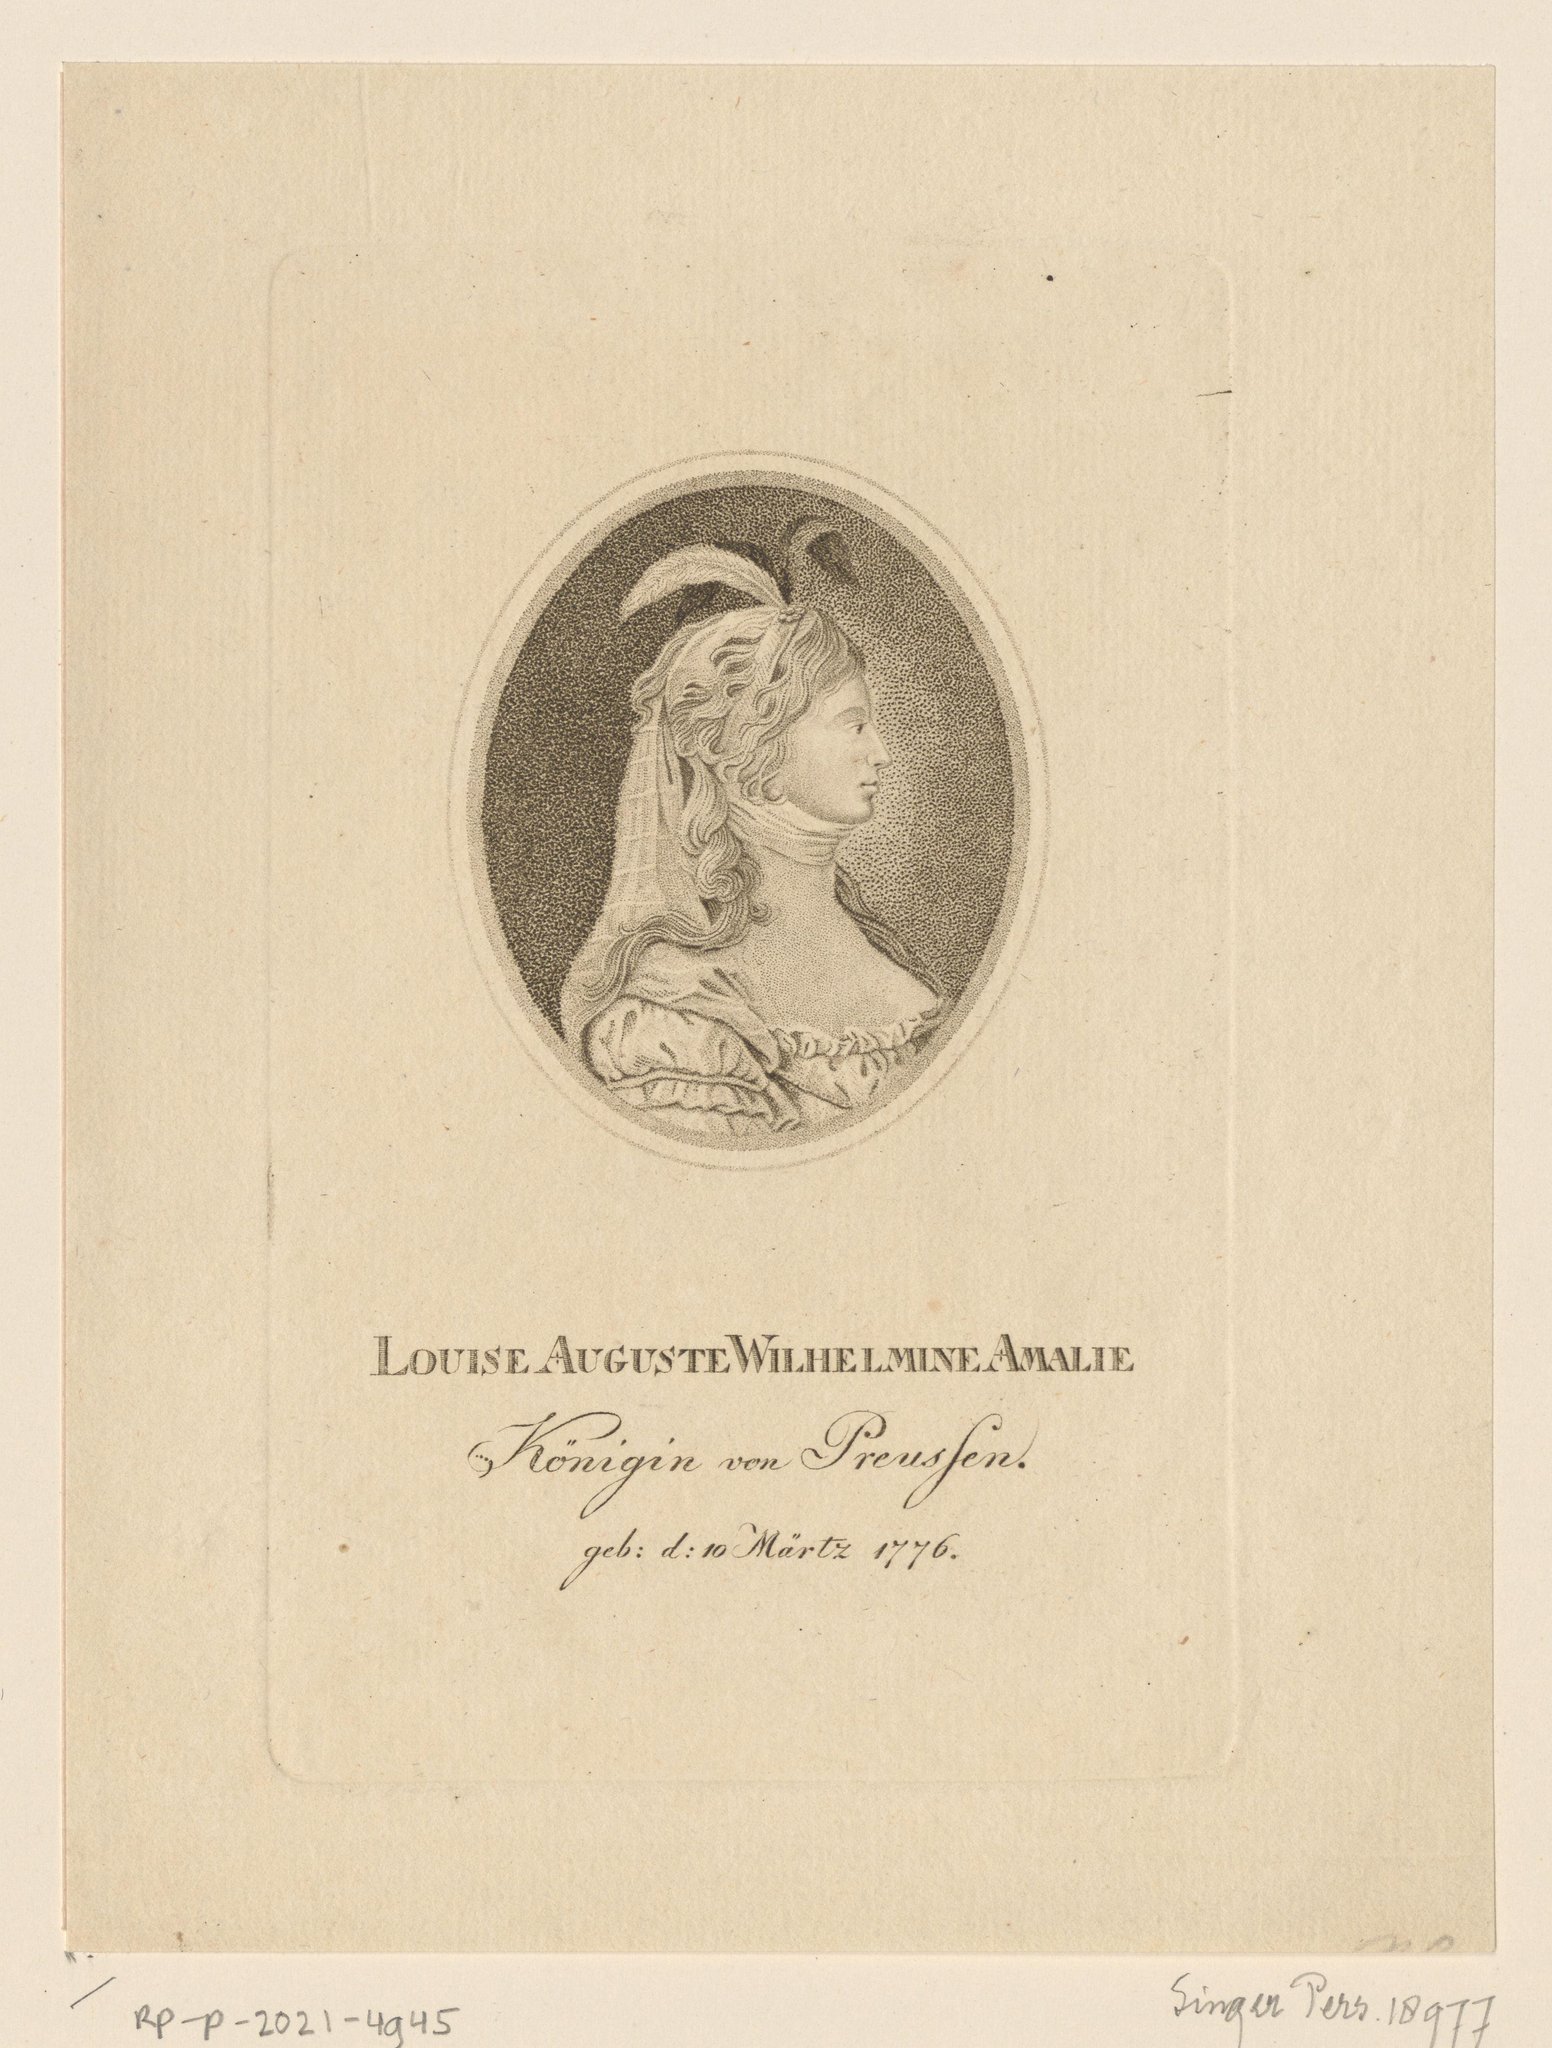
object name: print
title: Portret van Louise van Mecklenburg-Strelitz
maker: Anonymous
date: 1797-1810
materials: paper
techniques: stippling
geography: germany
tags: historical persons - bb - woman, queen